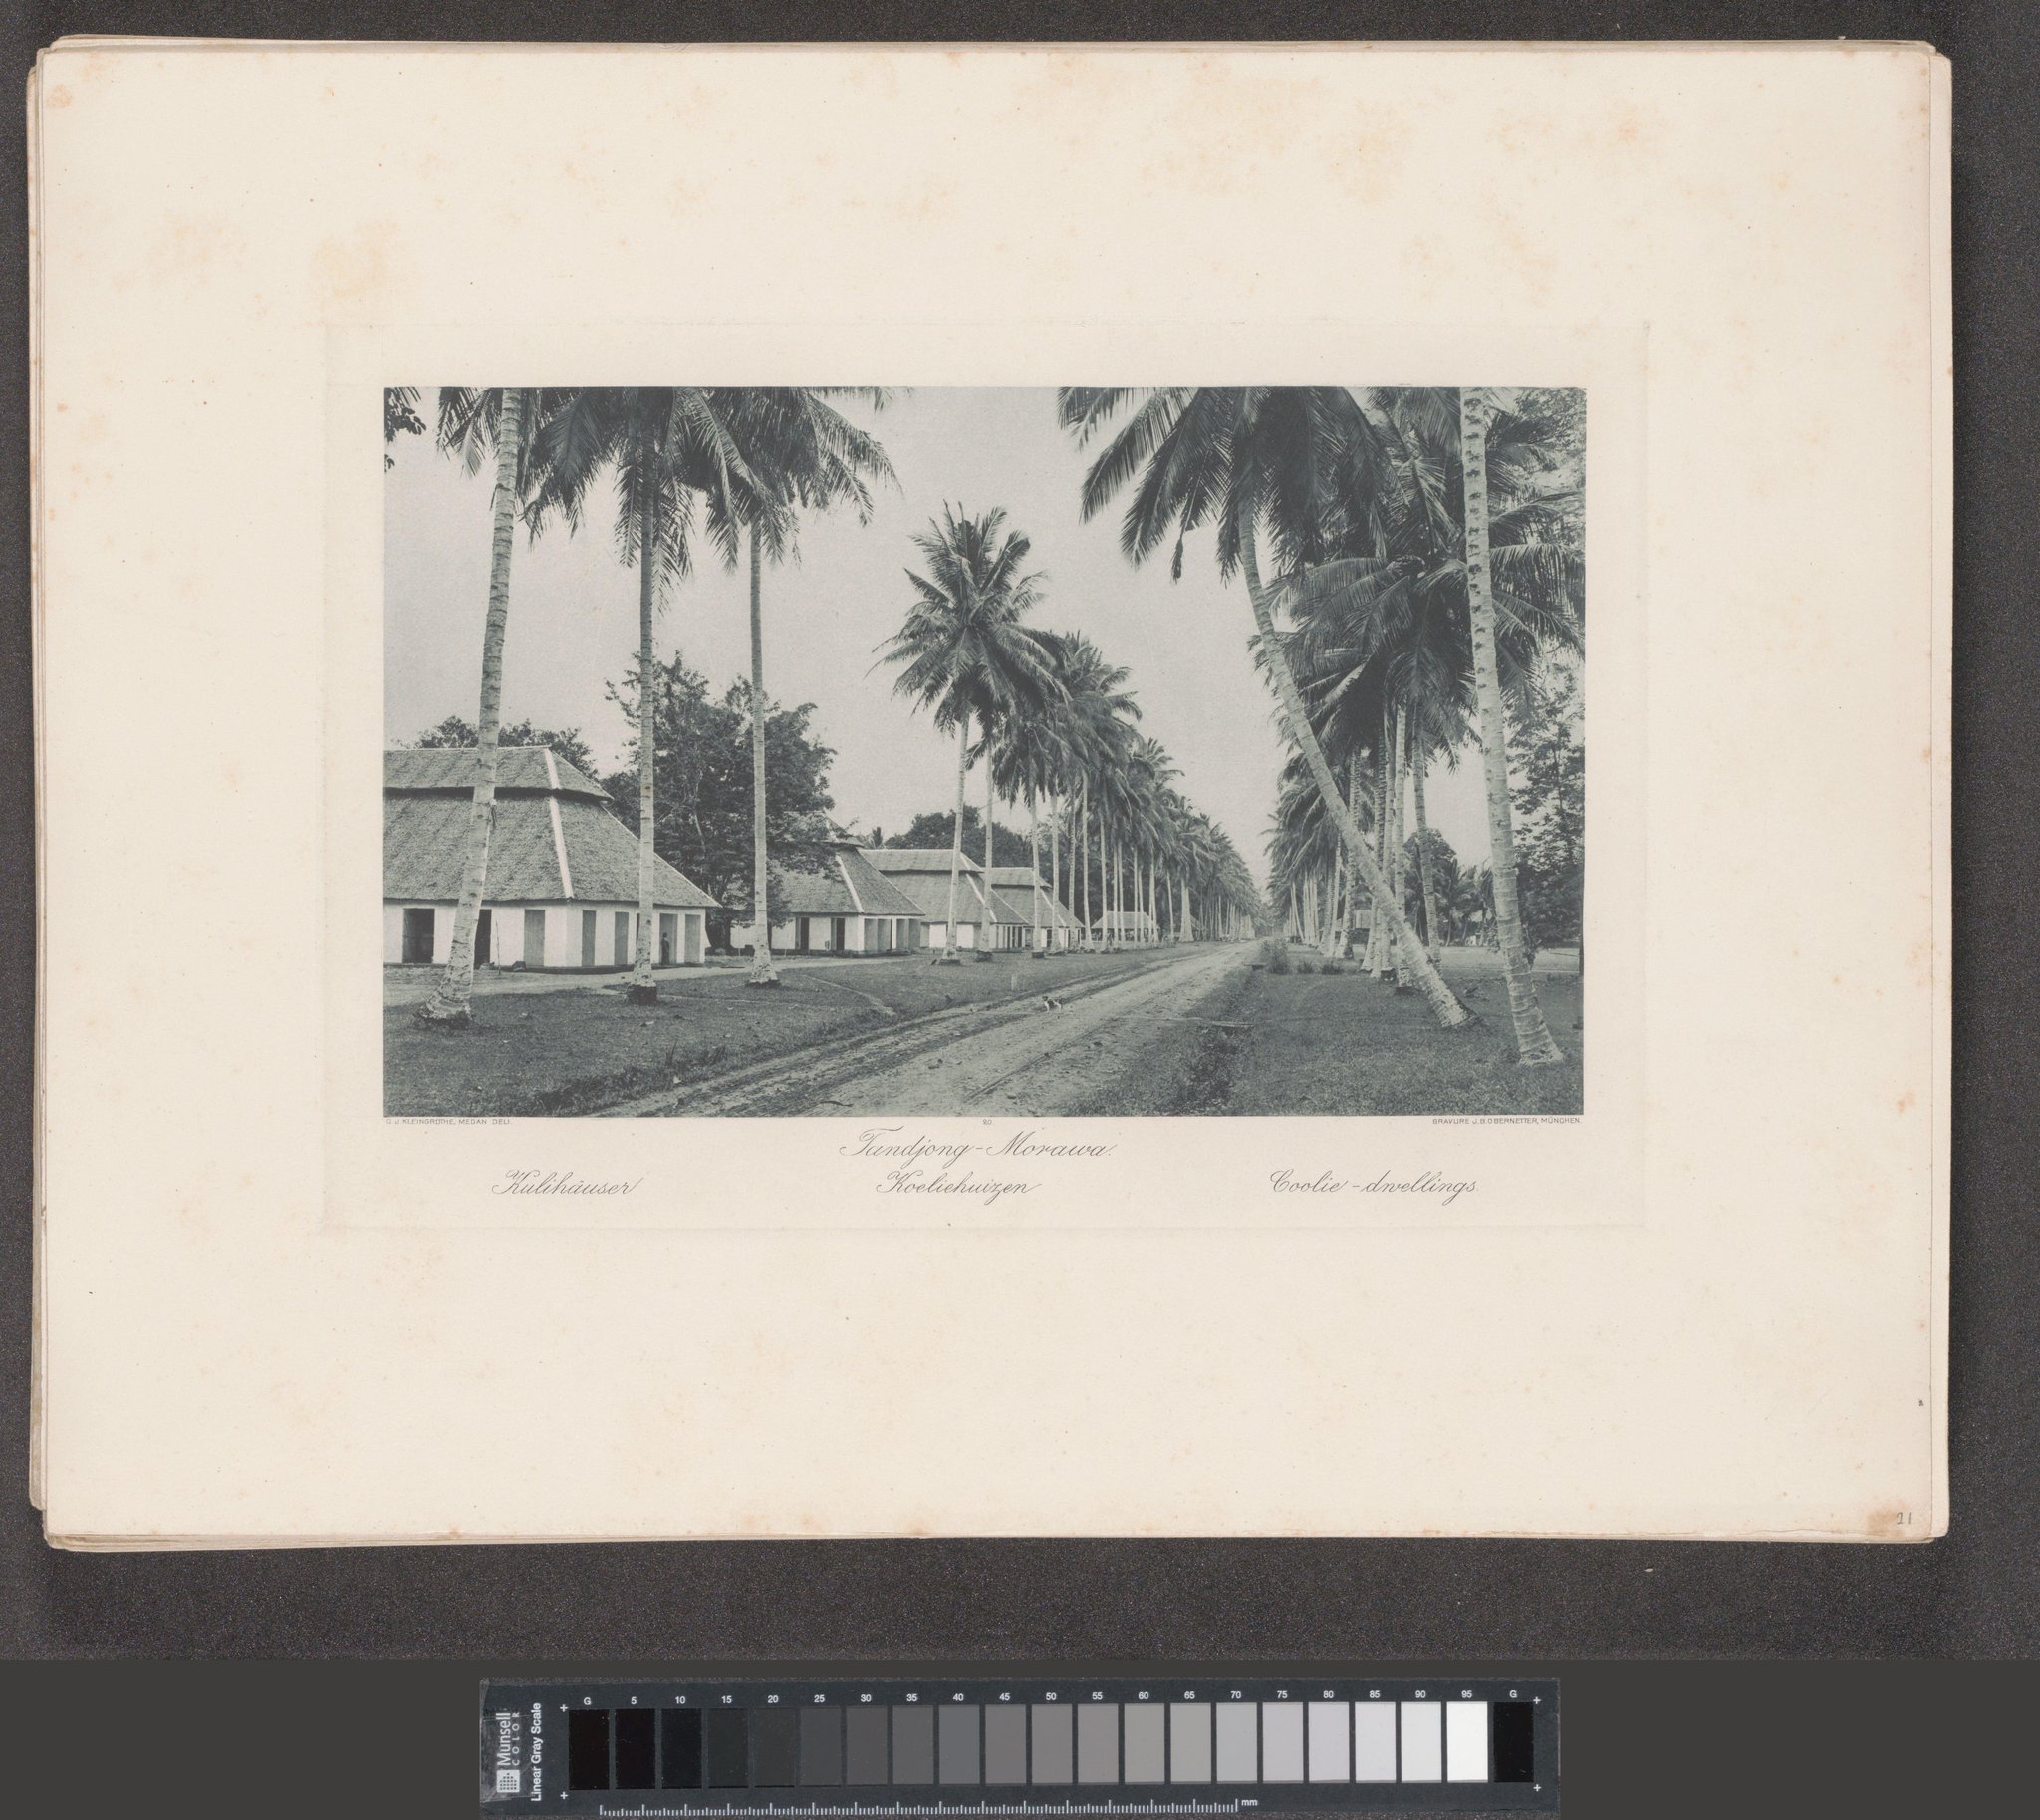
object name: photomechanical print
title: Tandjong-Morawa Koeliehuizen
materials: paper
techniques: photoaquatint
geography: munich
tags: rural housing, e.g. country-house, villa, cottage, working class, labourers, forest path or lane, trees: palm-tree, sumatra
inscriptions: number: ‘20’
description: Onderdeel van Album met heliogravures van Sumatra's oostkust.